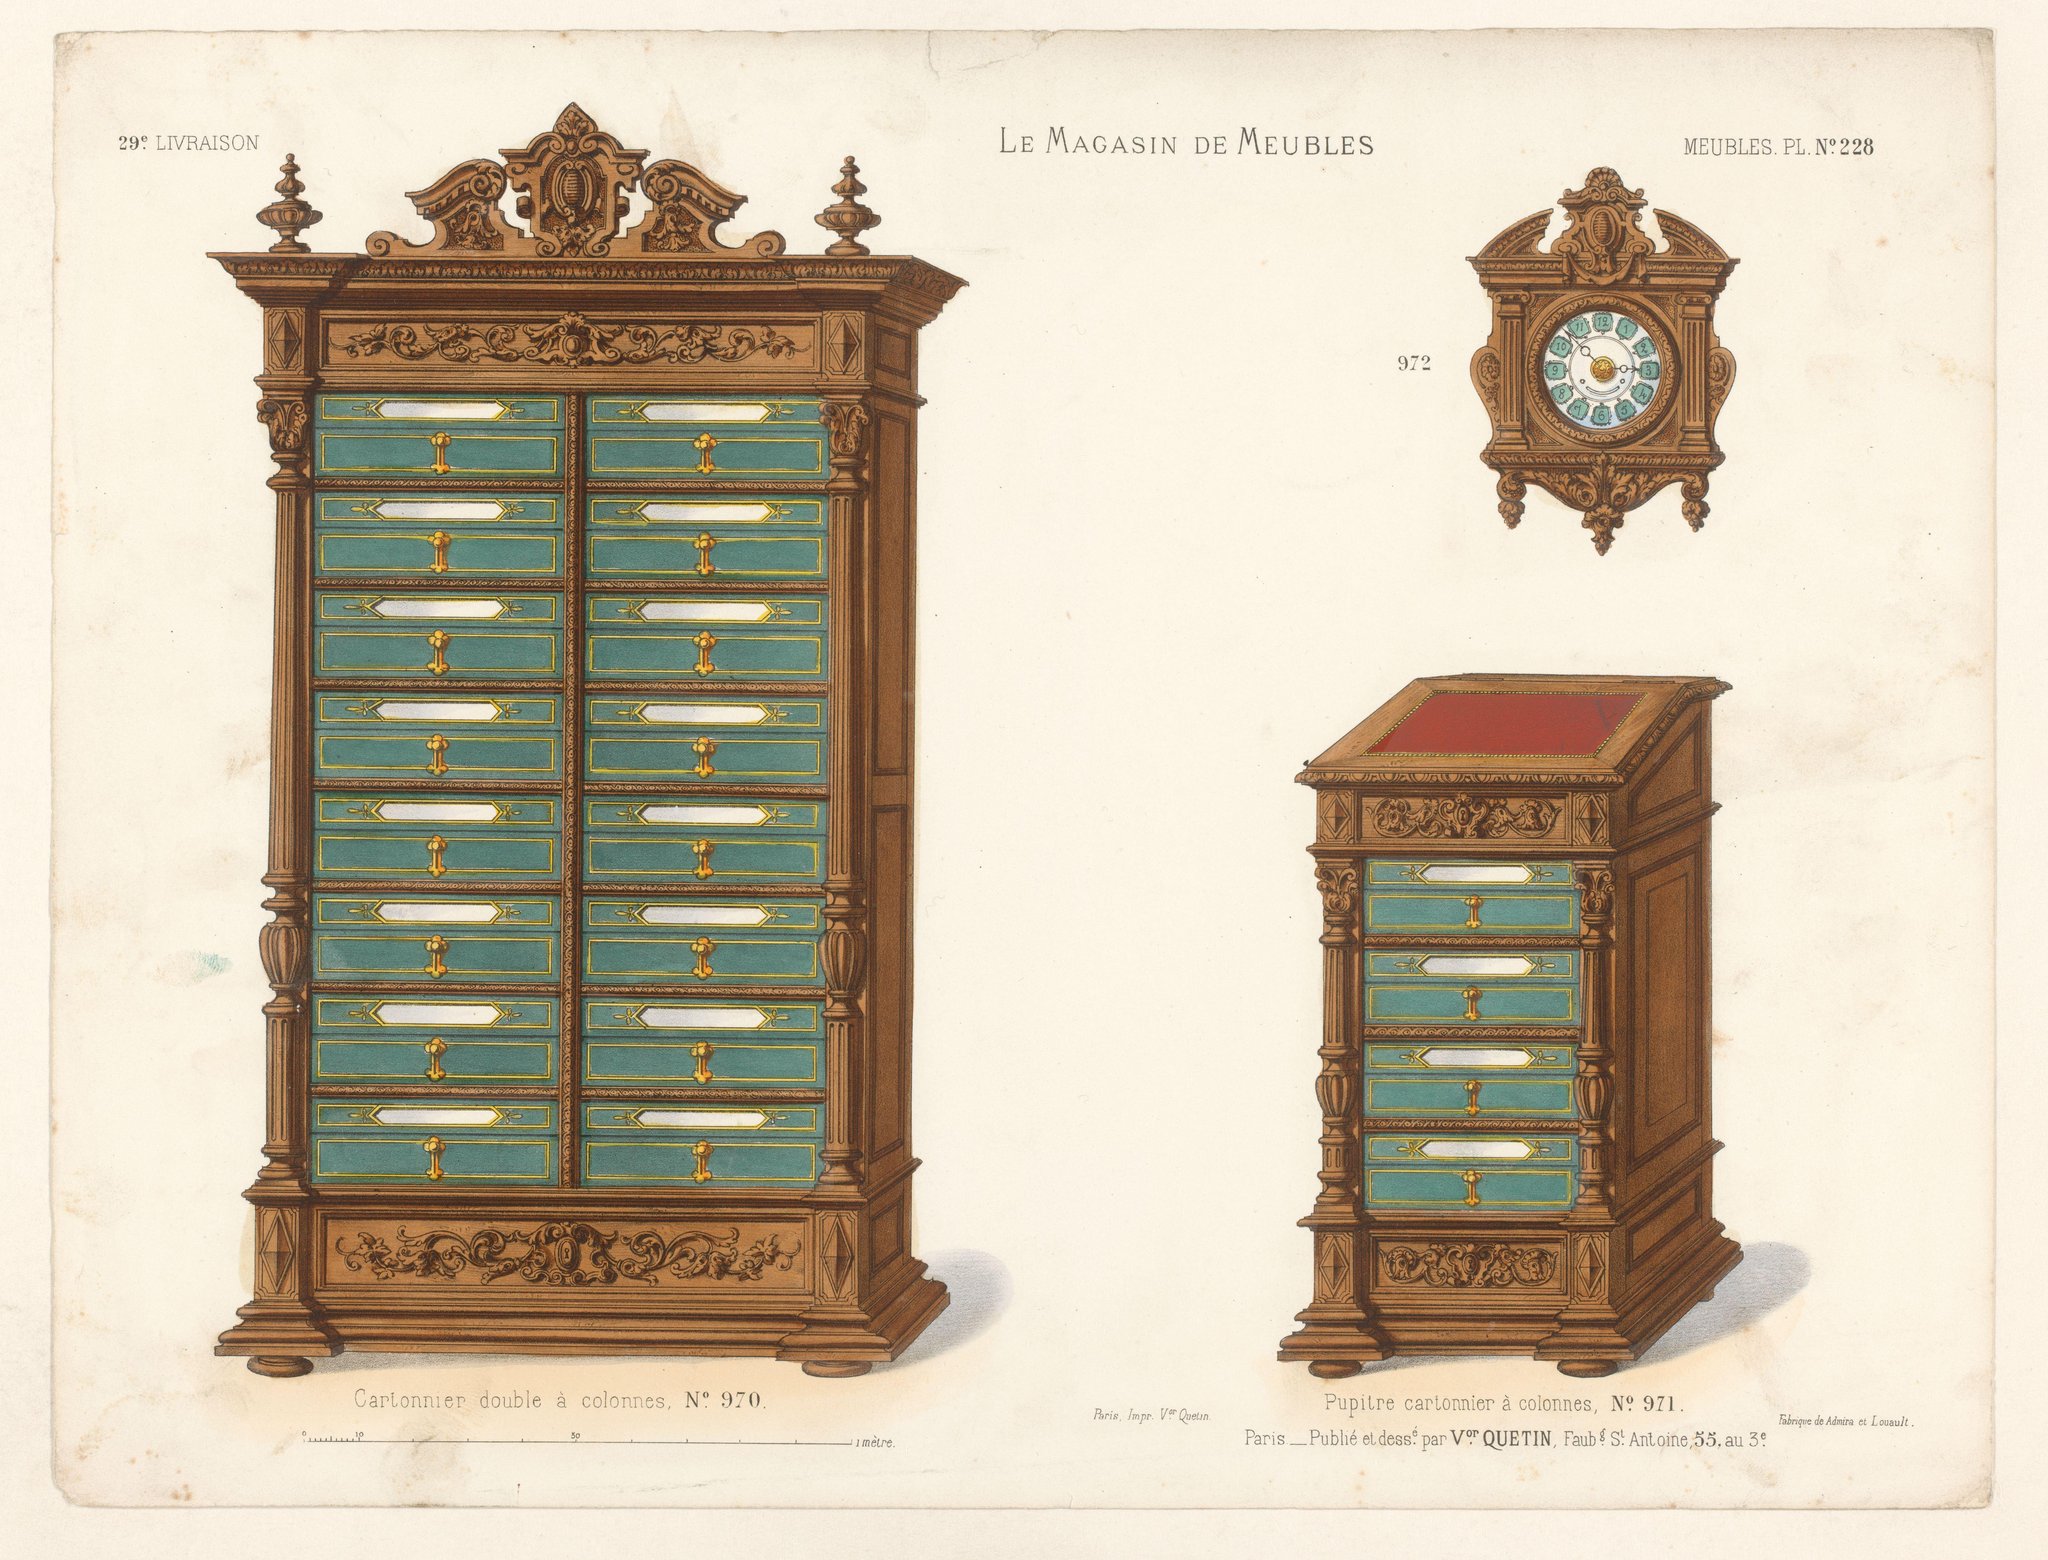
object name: print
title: Twee ladekasten en een klok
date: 1832-1877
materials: paper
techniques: hand coloring, lithograph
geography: paris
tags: furniture for storage, clock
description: Twee ladekasten en een wandklok. Prent uit 29e Livraison.